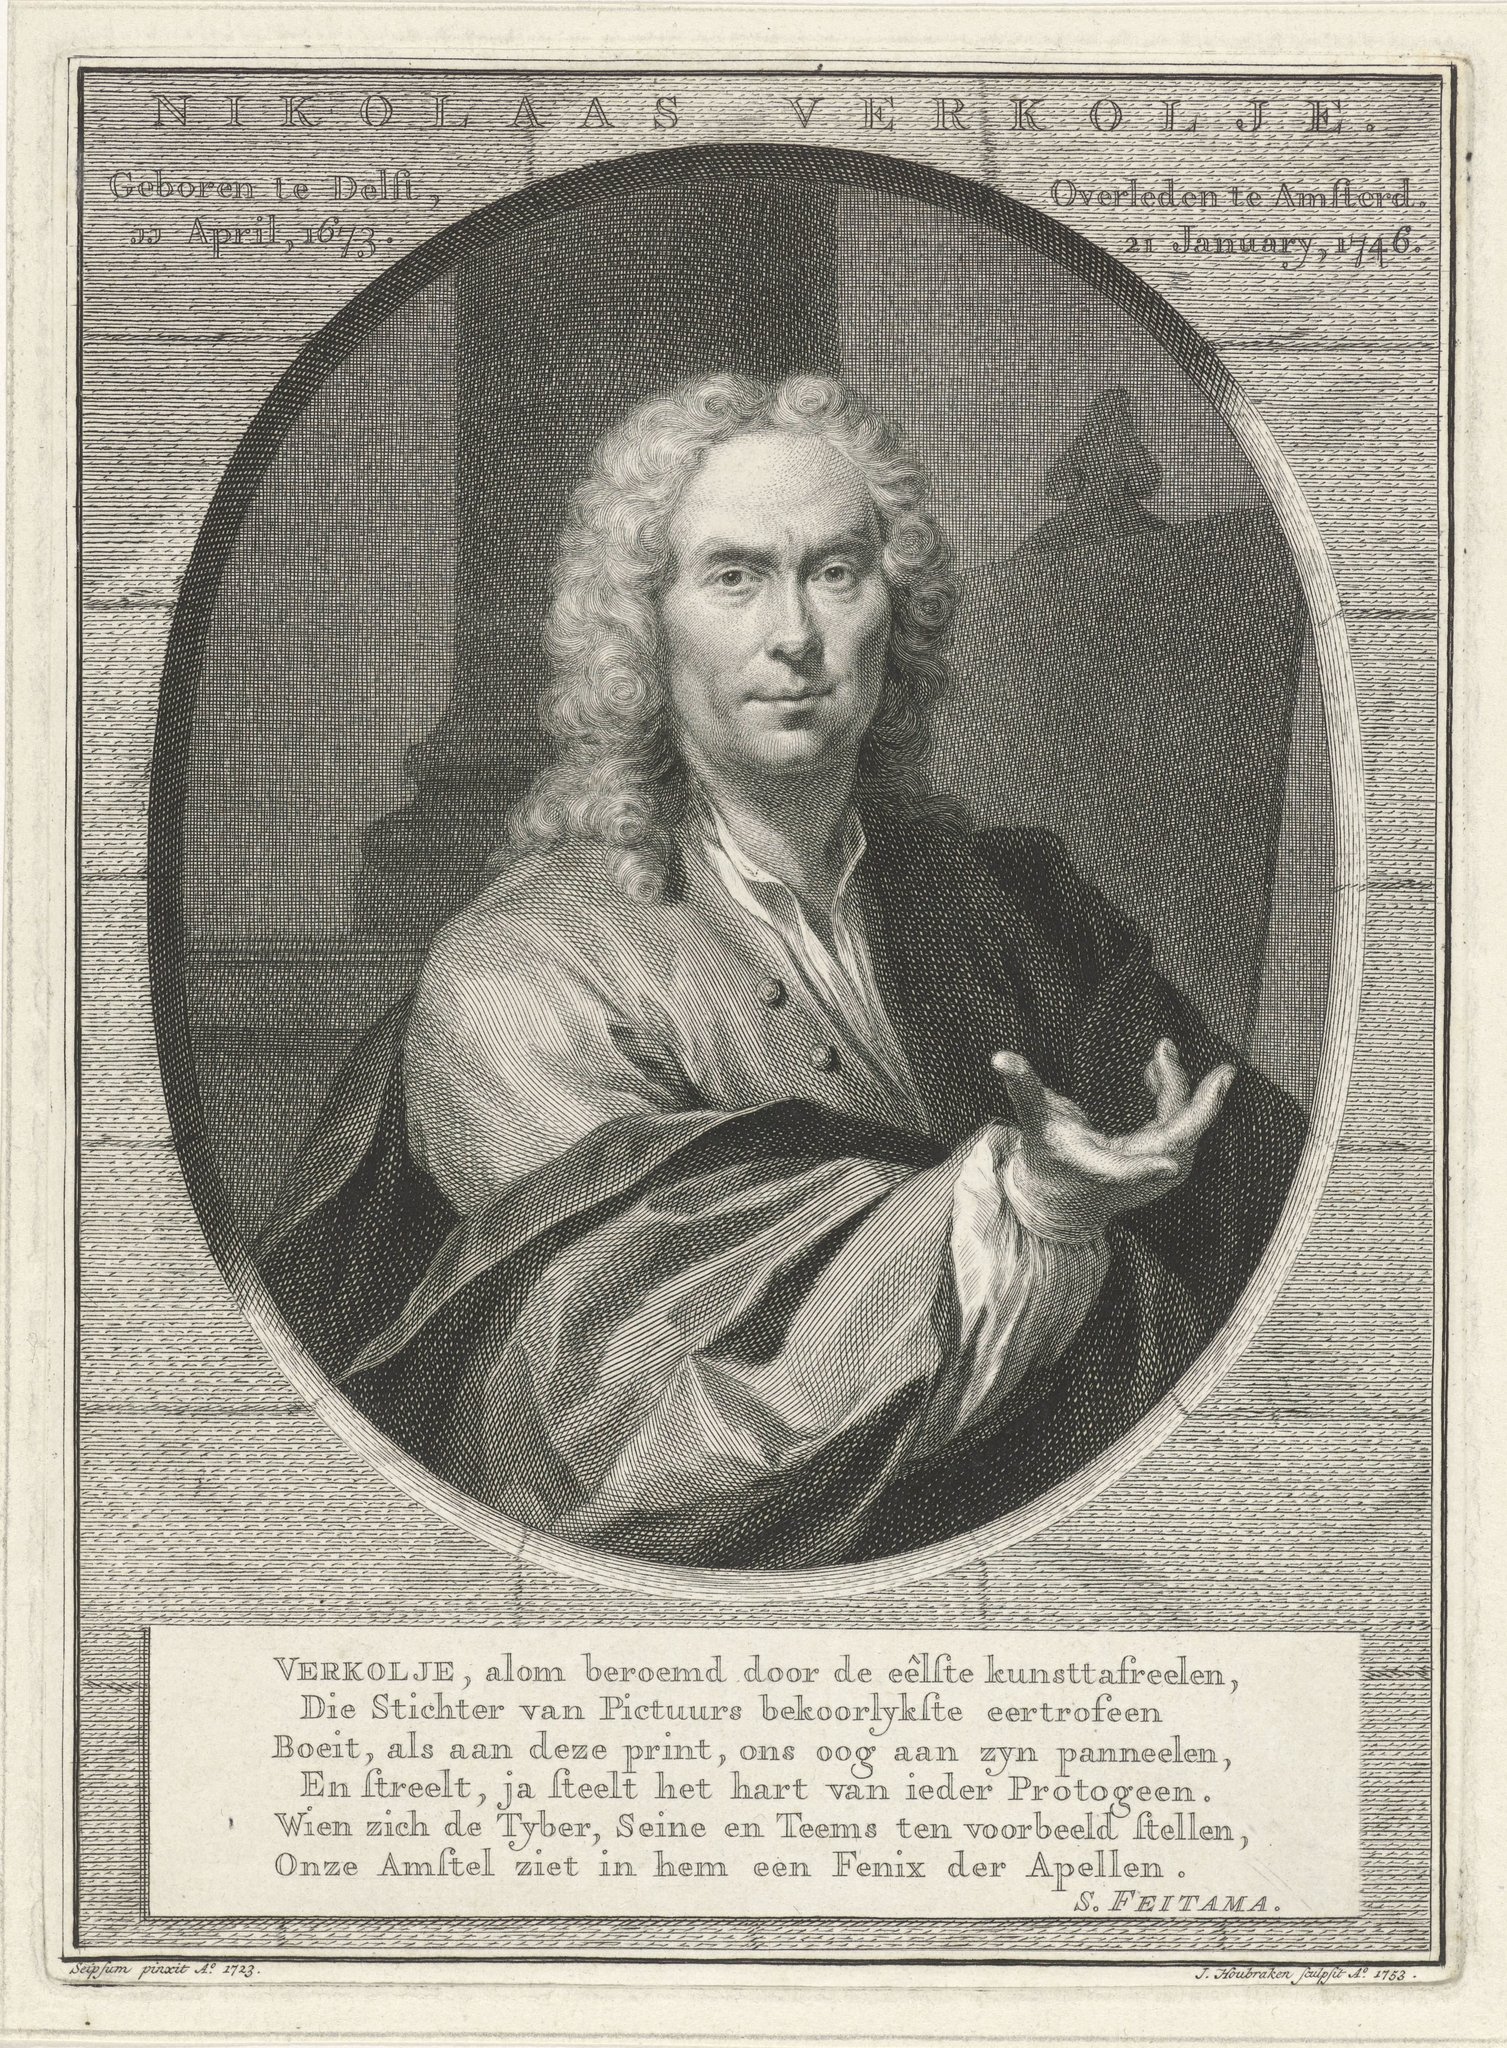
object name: print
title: Portret van Nicolaas Verkolje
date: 1753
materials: paper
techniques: engraving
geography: amsterdam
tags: delft, draughtsman, nicolaas verkolje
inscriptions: collector's mark: Lugt 240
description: Portret ten hlaven lijve naar rechts van Nicolaas Verkolje in een architectonisch ovaal, met achter hem een zuil en een schildersezel. Boven het portret zijn naam en gegevens in drie regels in het Nederlands en onderaan een zesregelig vers in het Nederlands.